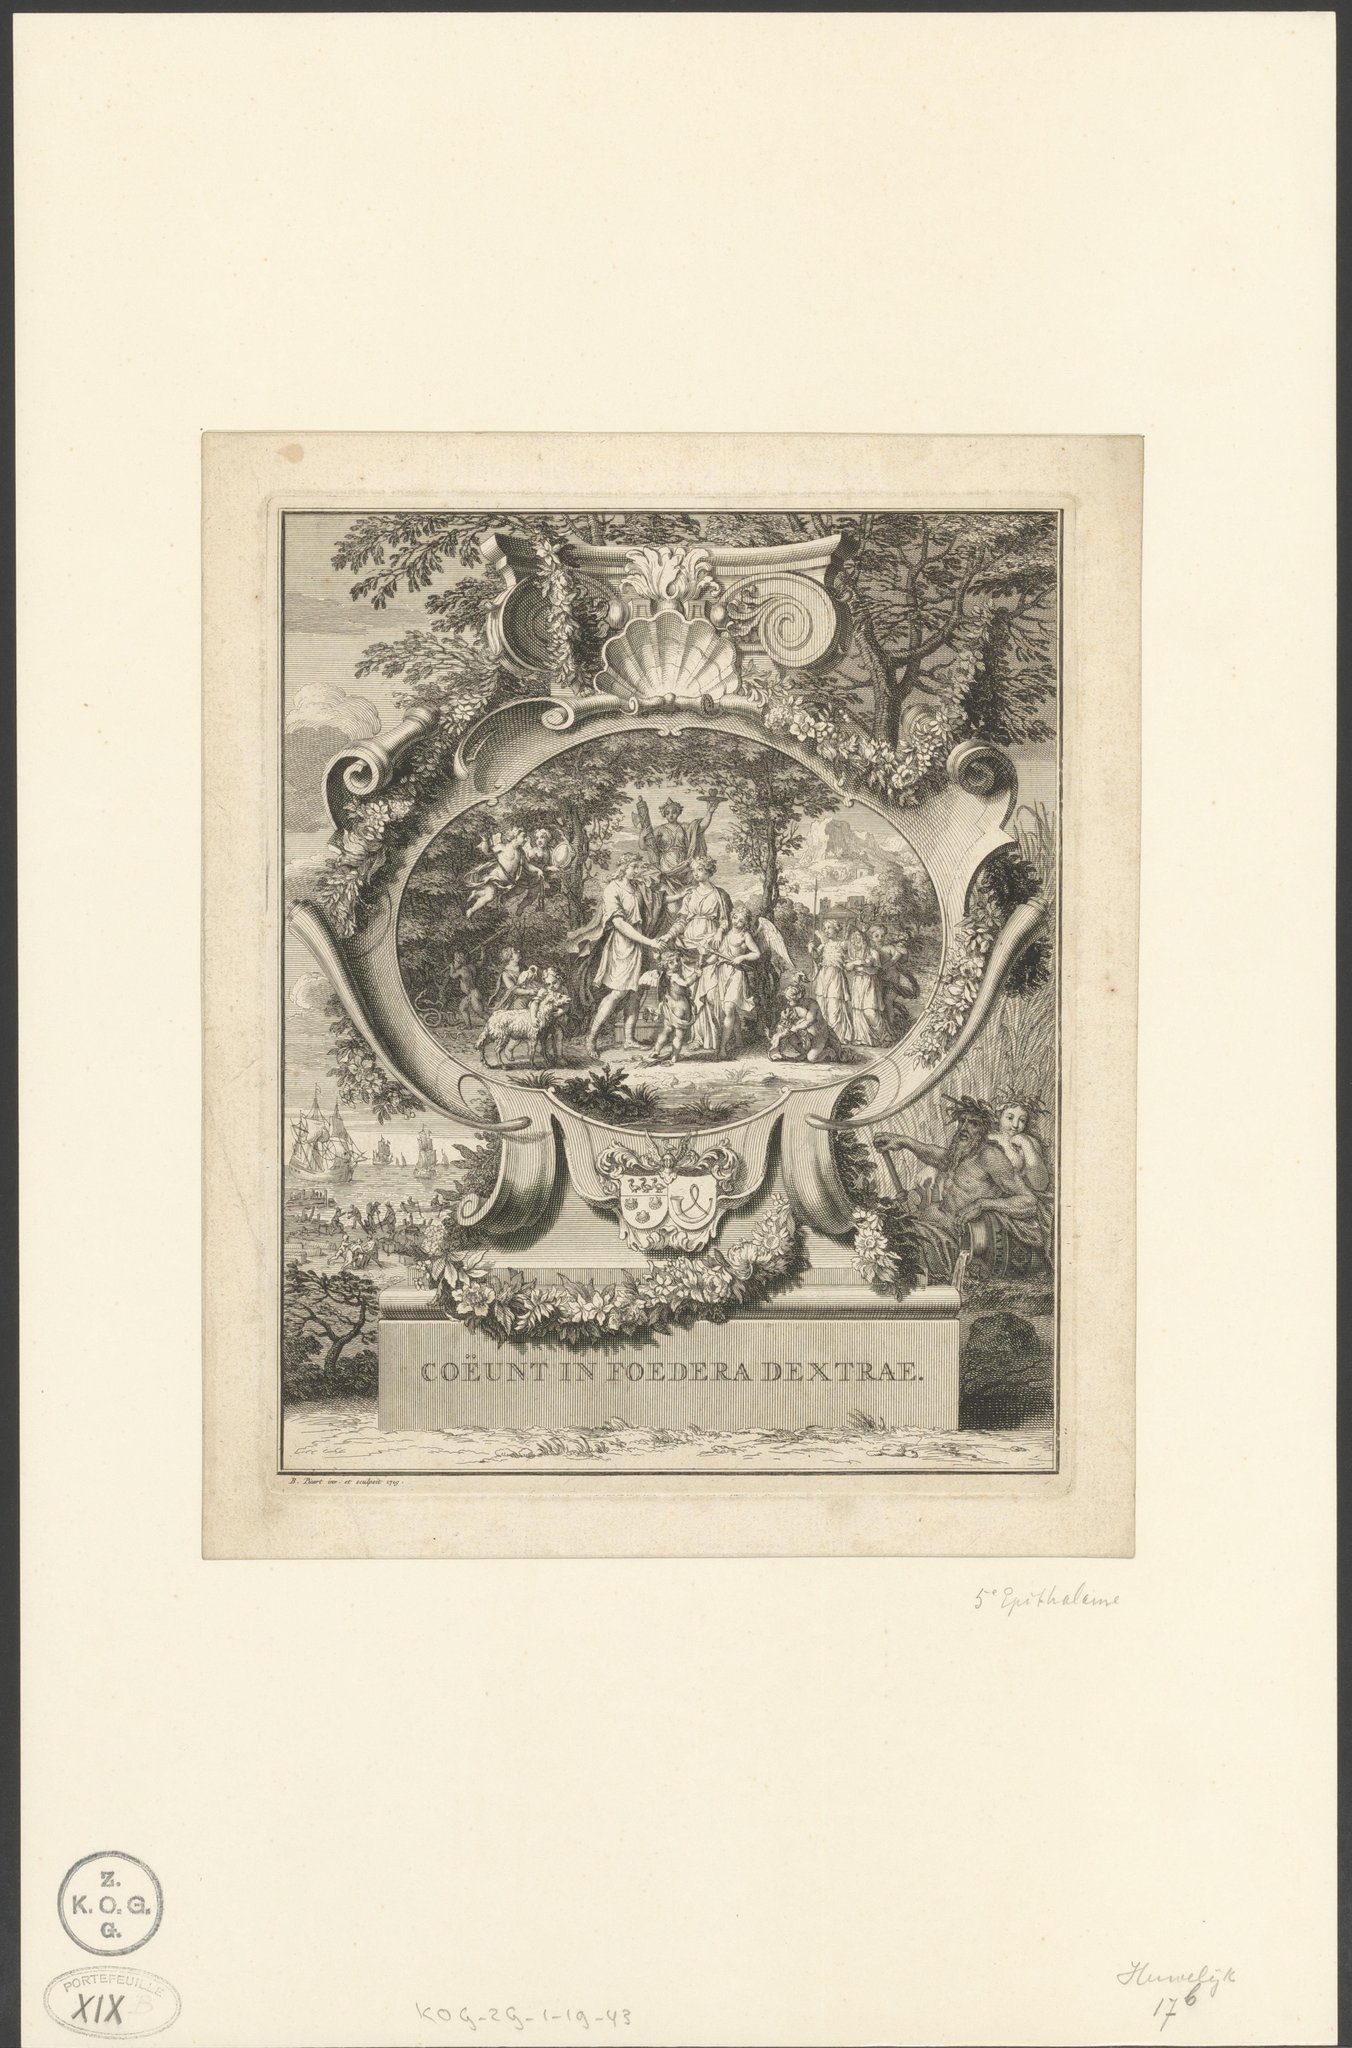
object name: print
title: Bruiloftsprent, 1719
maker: bernard picart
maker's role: draughtsman, print maker, publisher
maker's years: 1673-1733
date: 1719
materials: paper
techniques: engraving, etching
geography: netherlands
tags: river personified, 'fiumi' (ripa), (civil) marriage ceremonies, merchant shipping, shipping trade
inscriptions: collector's mark: Lugt 1641, collector's mark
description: Bruiloftsprent uit 1719 met een allegorische voorstelling van een huwelijk in een cartouche. Onderaan twee familiewapens en de spreuk 'Coëunt in foedera dextrae'. Rechtsonder riviergoden, linksonder koopvaardij. Onderwerpsrubrieken binnen de Atlas Zeden en Gewoonten: Des Menschen Begin, Midden en Einde. Bruiloft en huwelijk.